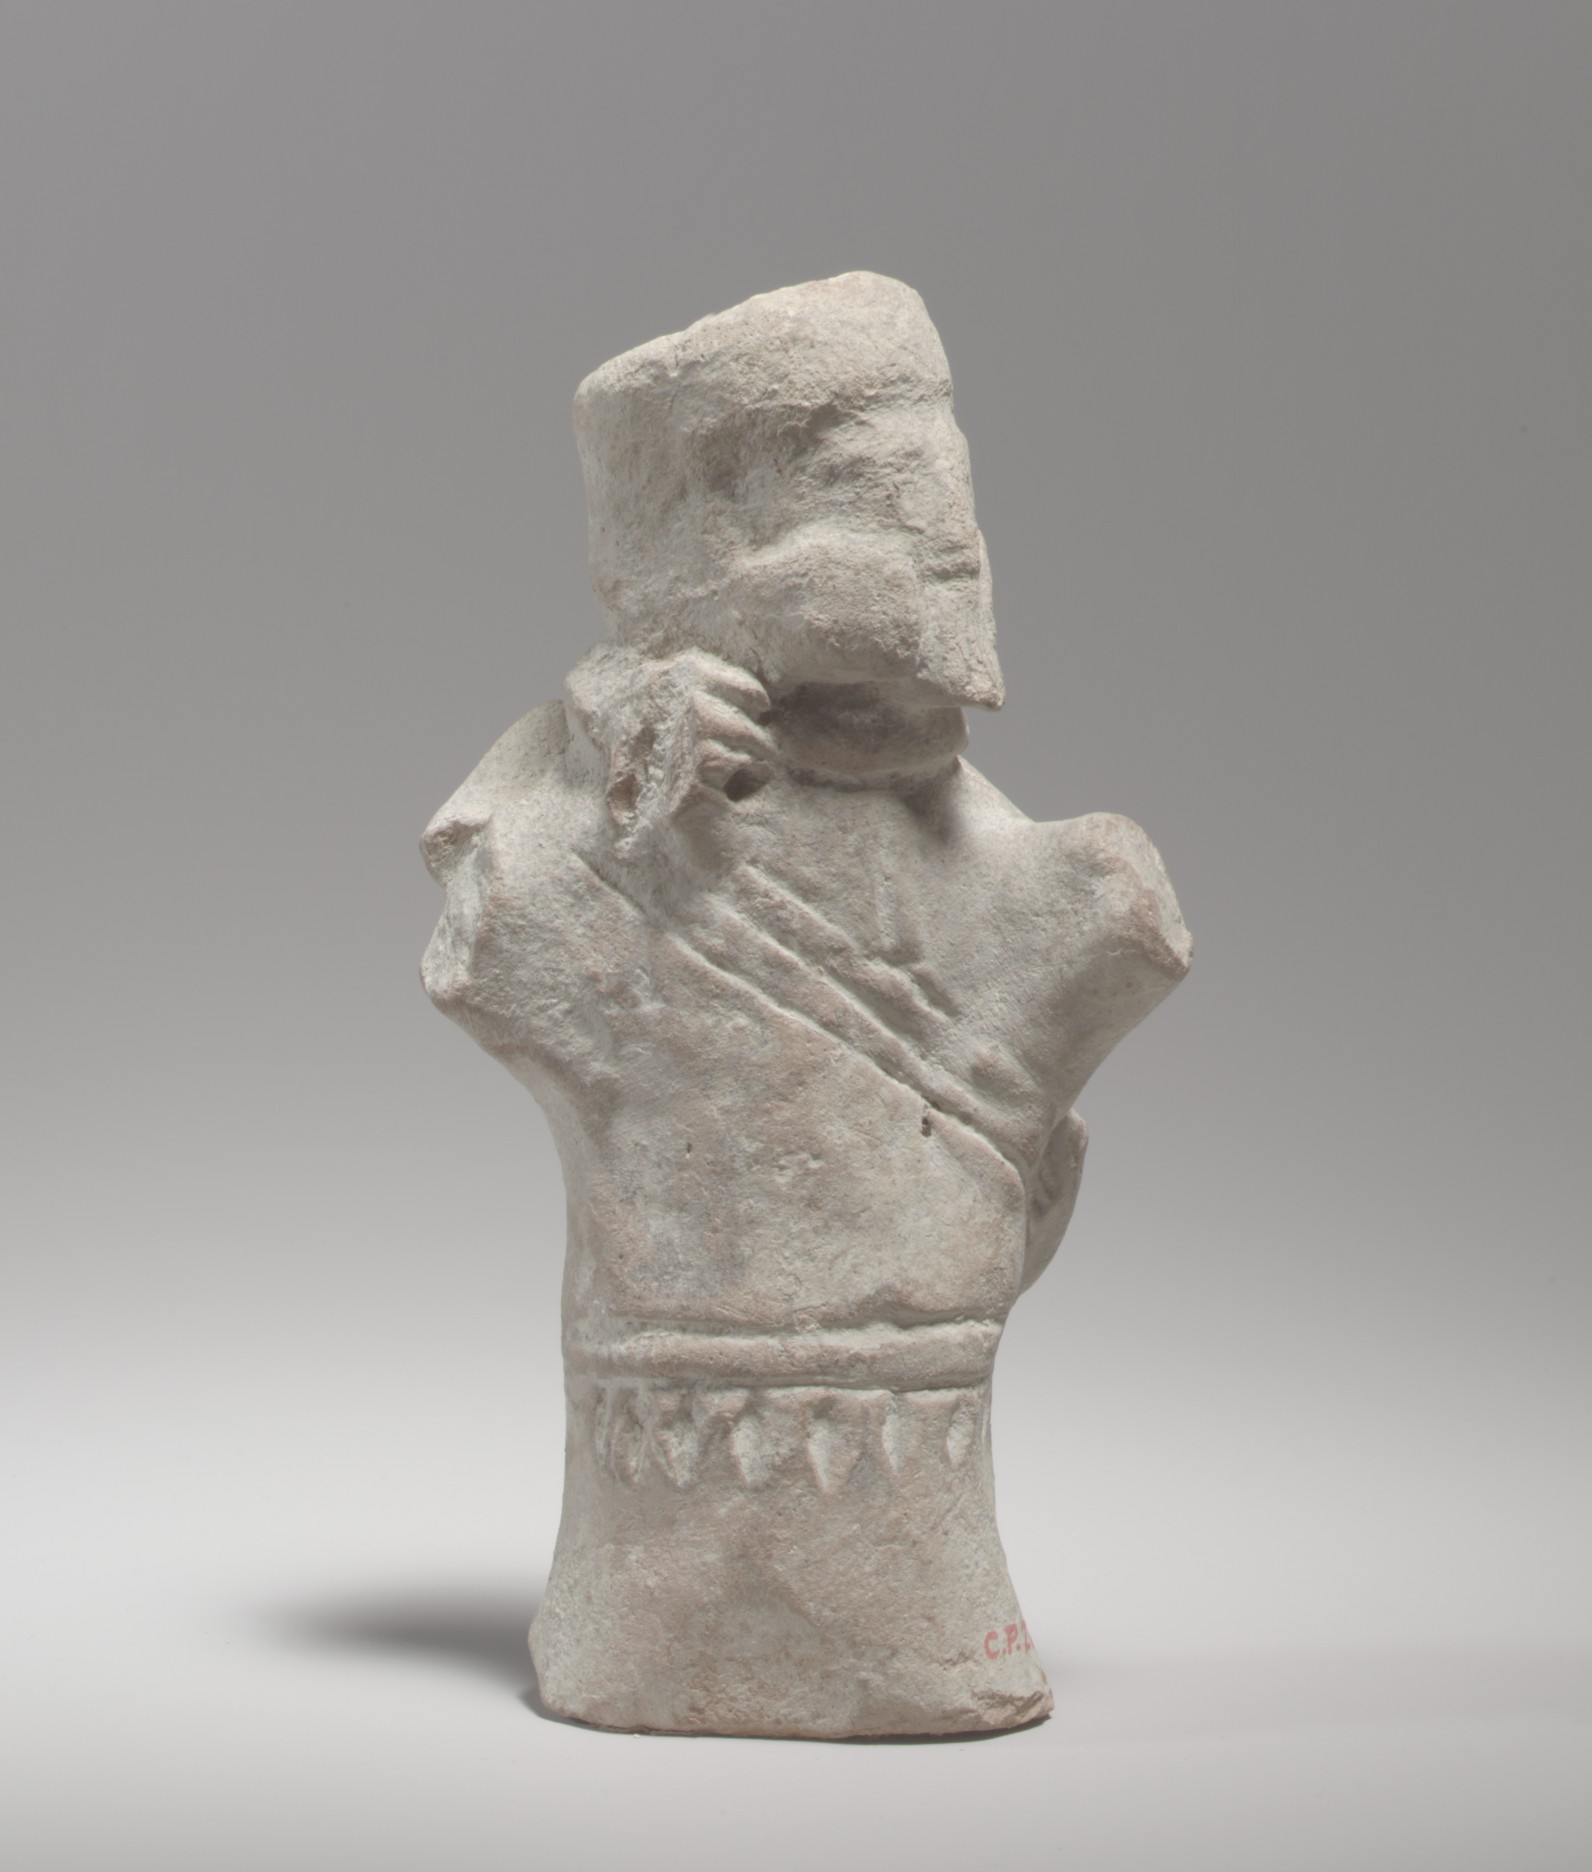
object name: statuette of herakles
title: Archer, probably from a chariot group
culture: cypriot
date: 750-600 BCE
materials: terracotta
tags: men